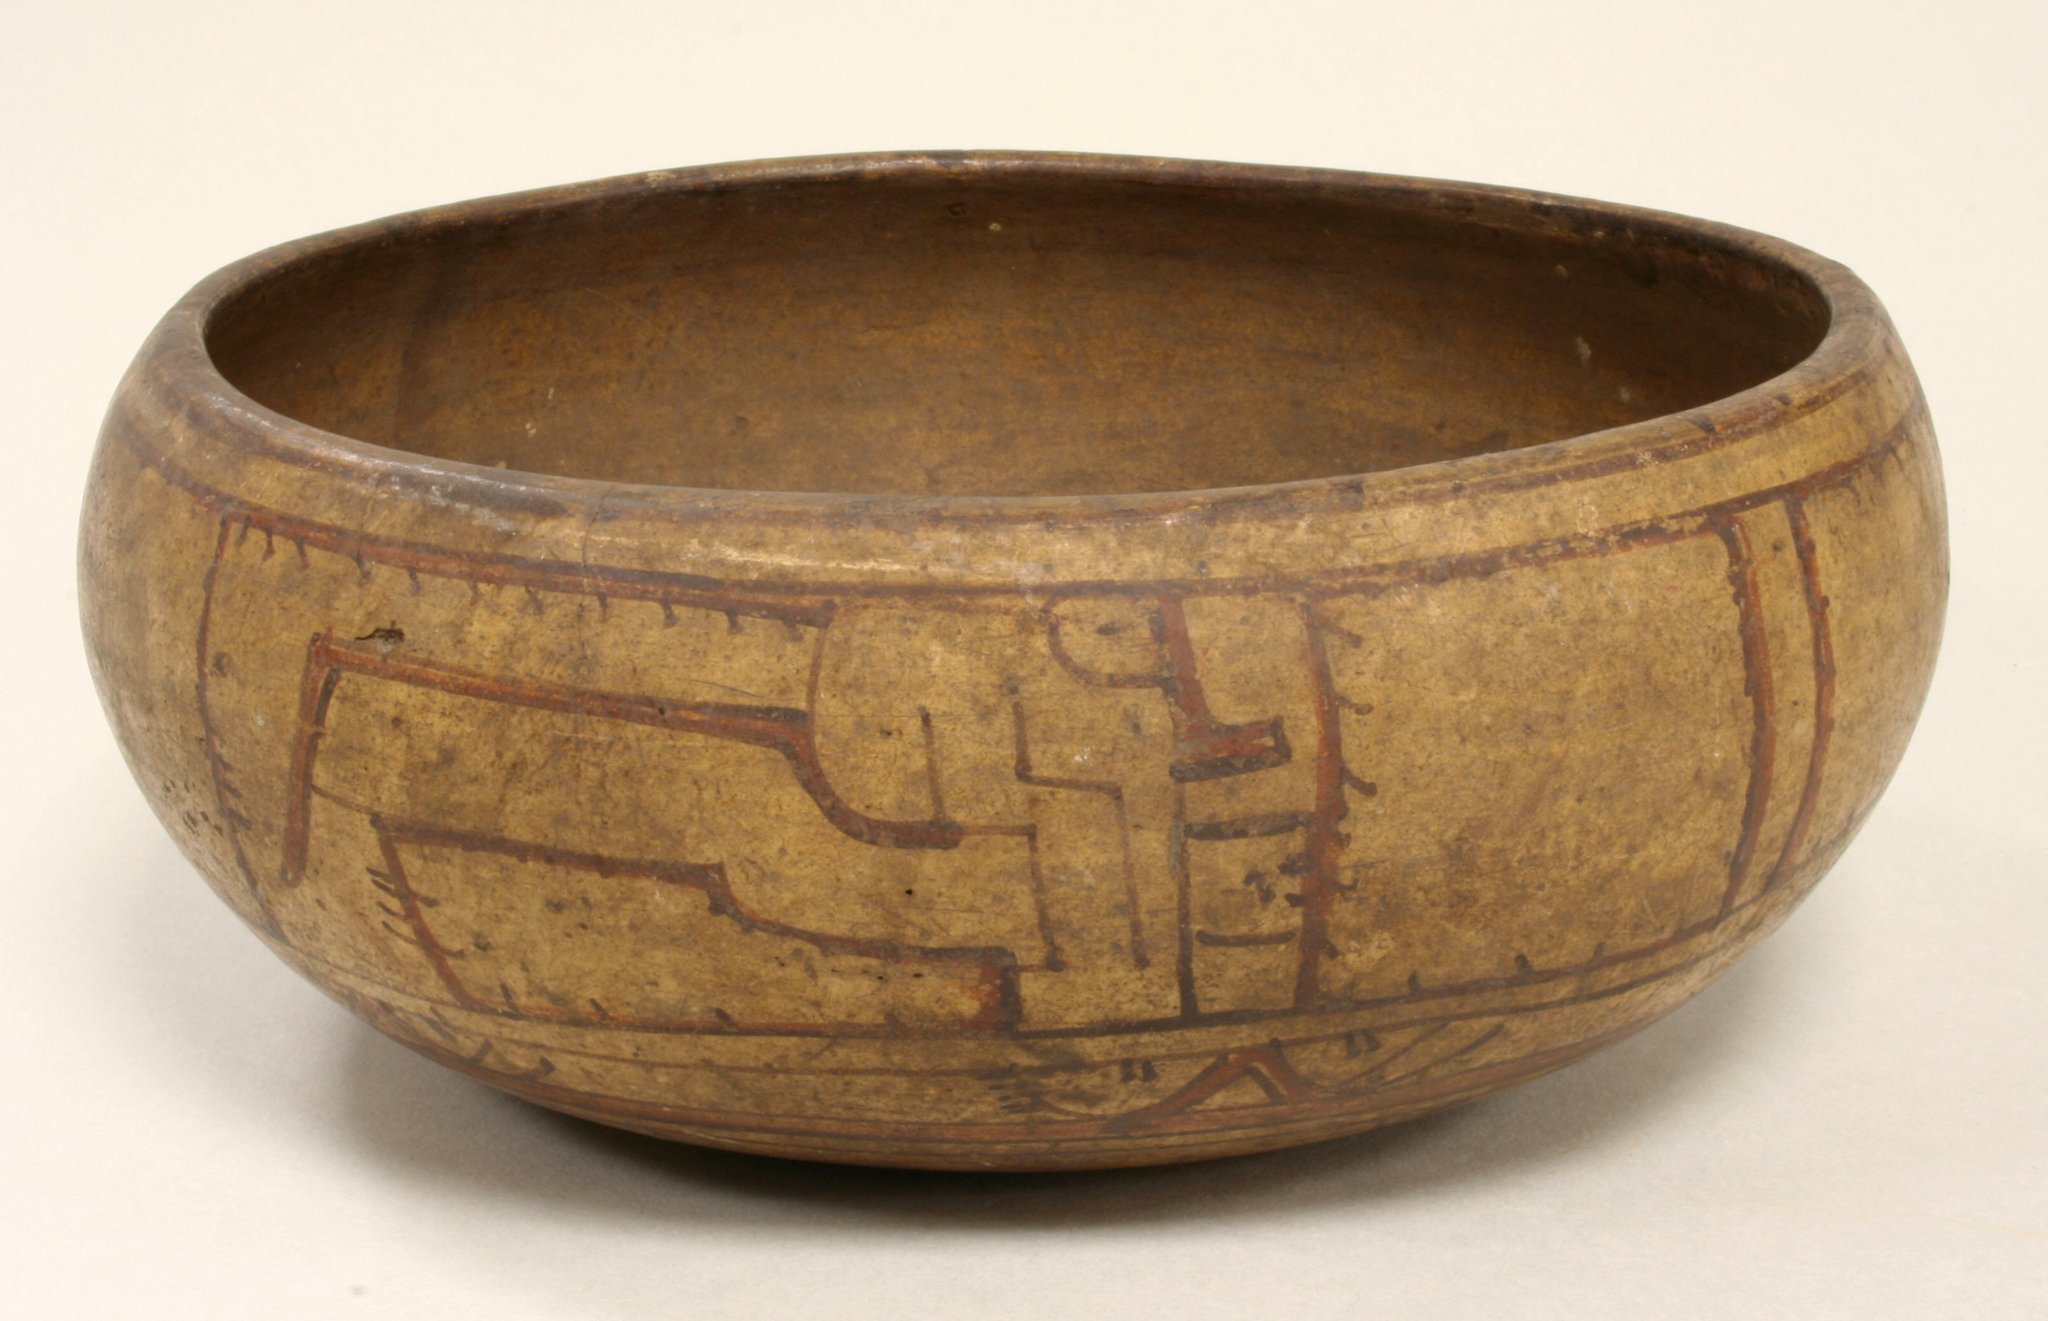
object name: bowl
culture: nicaragua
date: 1101-1500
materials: ceramic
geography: nicaragua